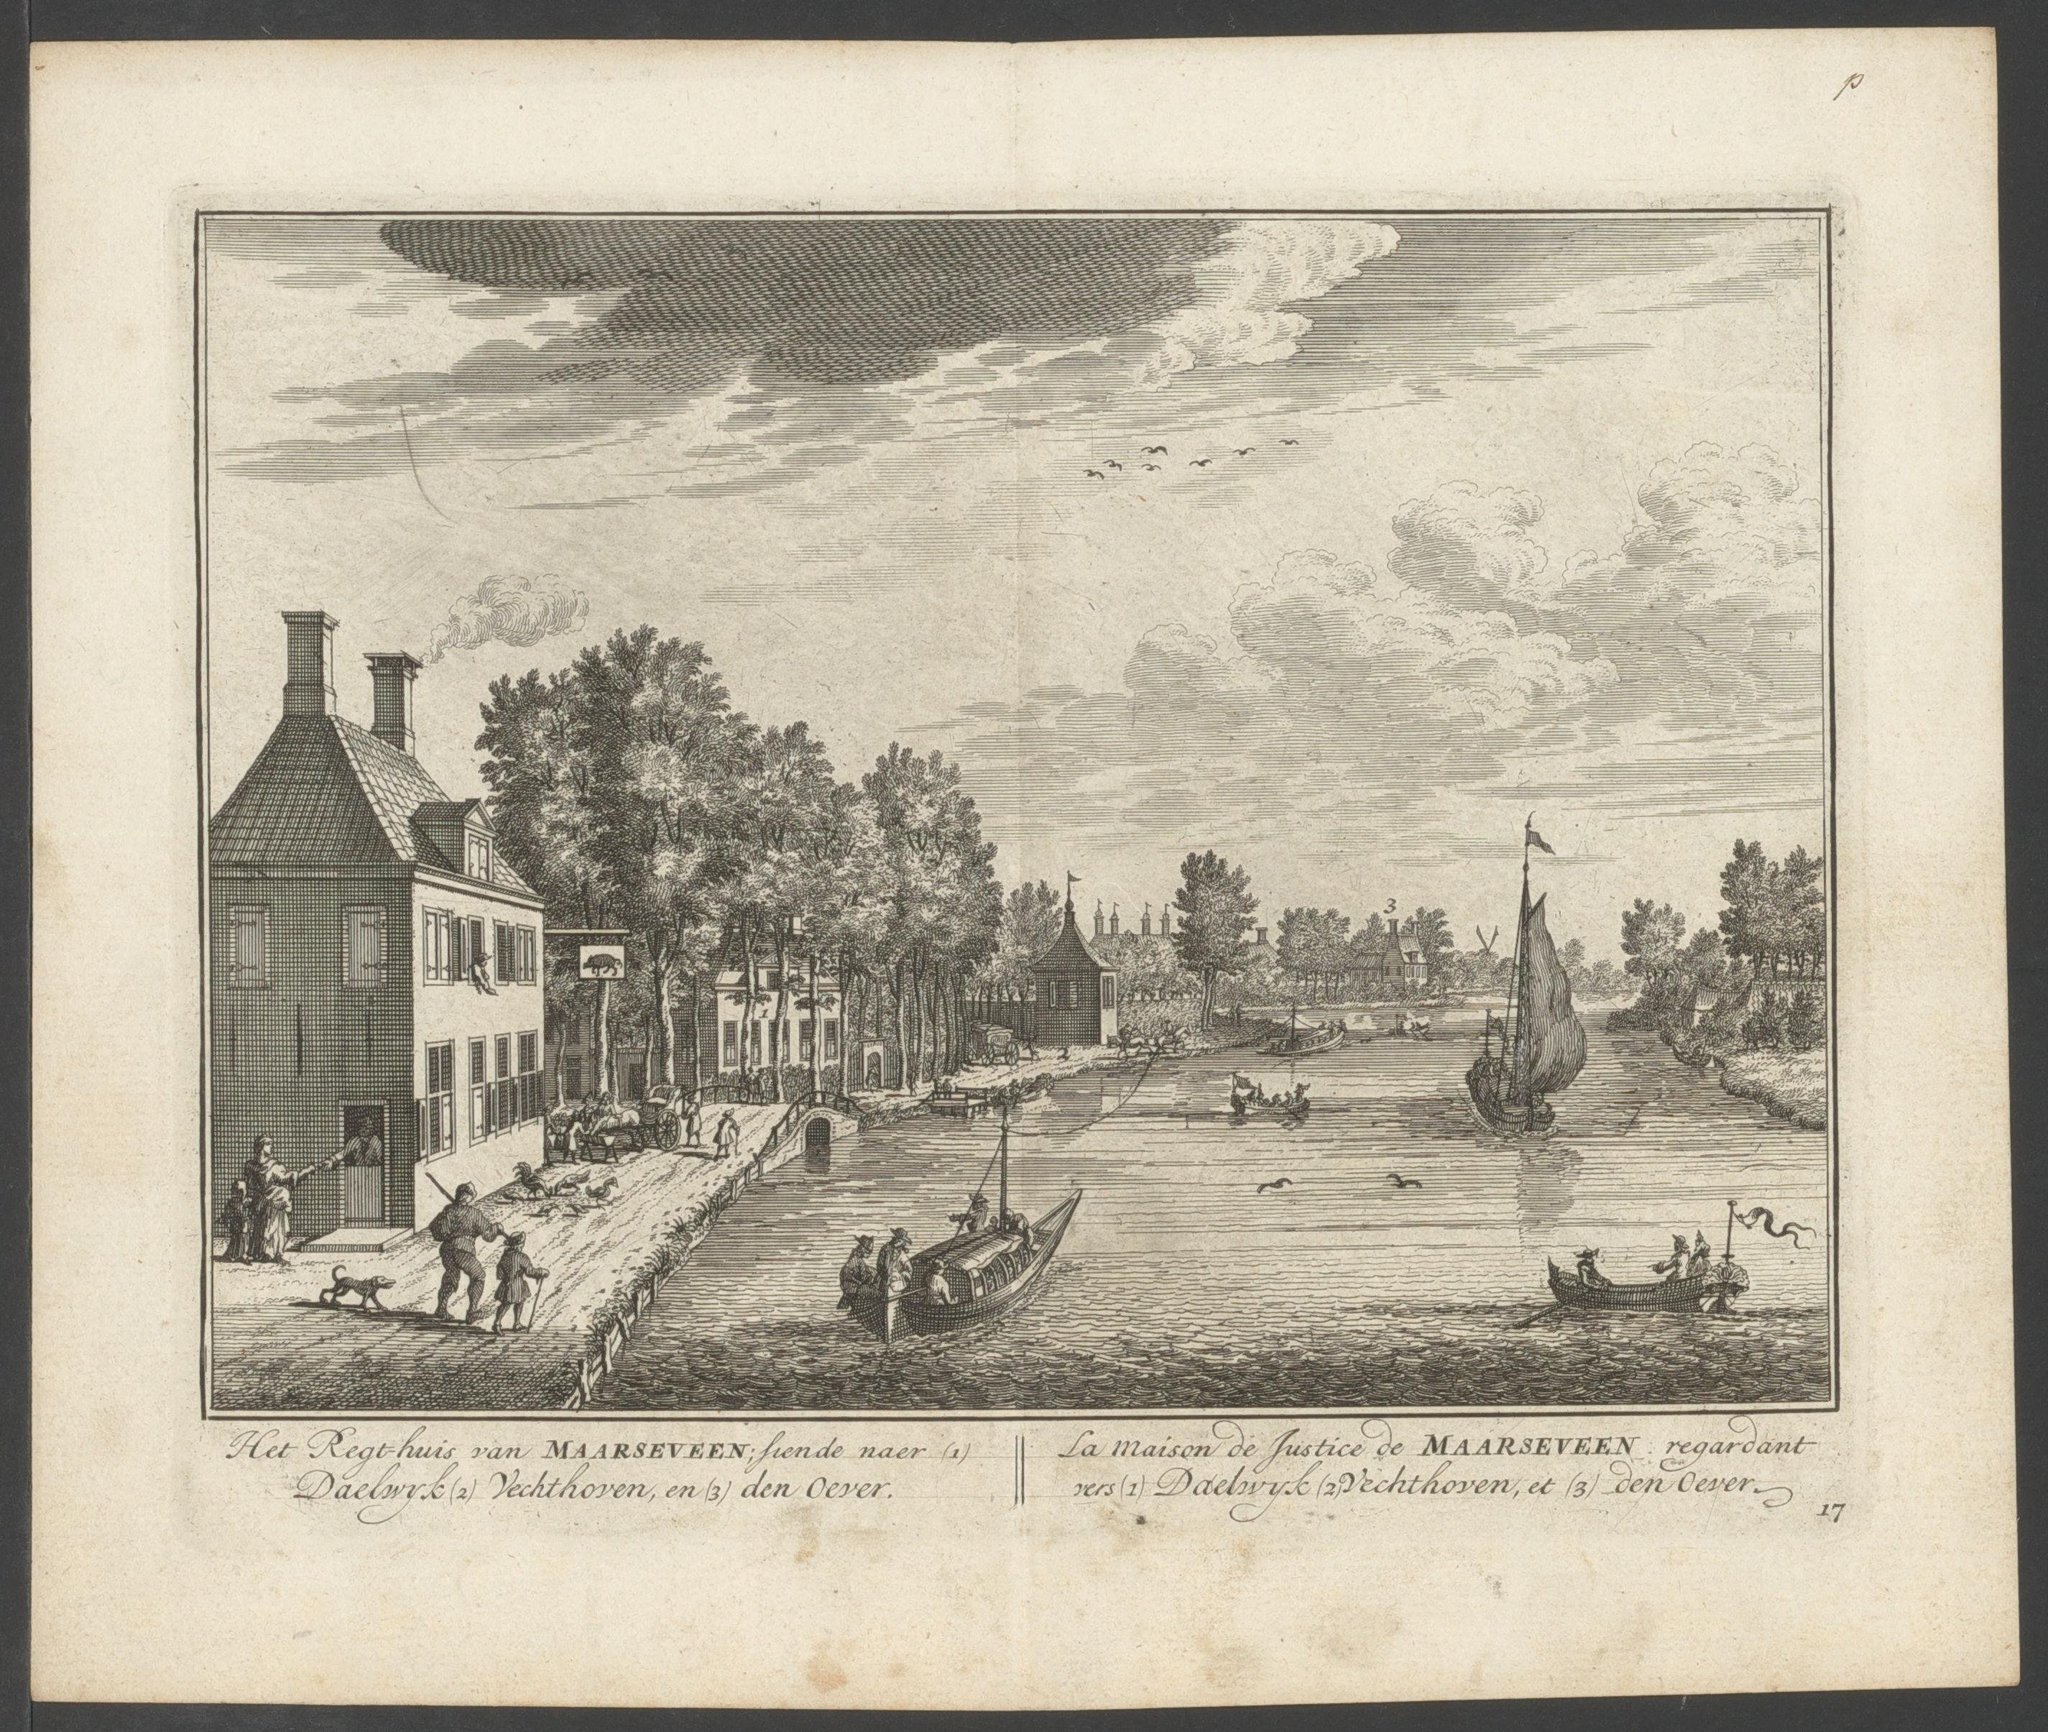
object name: print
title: Het Dorp Den Berg, nevens het Gesigt naer Nigtevecht / Le Village Den Berg, avec la Veue vers Nigtevecht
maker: daniël stopendaal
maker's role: print maker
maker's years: 1672-1726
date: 1719-1790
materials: paper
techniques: engraving, etching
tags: river (+ landscape with figures, staffage), country-house, nederhorst den berg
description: Prent voor het eerst gebruikt in: Leth, Andries de. De zegepraalende Vecht, vertoonende verscheidene gesichten van lustplaatsen, heeren huysen en dorpen, beginnende van Uitrecht en met Muyden besluytende (...). Amsterdam: Weduwe Nicolaus Visscher, 1719. Prent mogelijk uit: Brouërius van Nidek, Matthaeus. De Vechtstroom, van Utrecht tot Muiden (...). Amsterdam: H. Gartman, W. Vermandel en J.W. Smit, 1790.